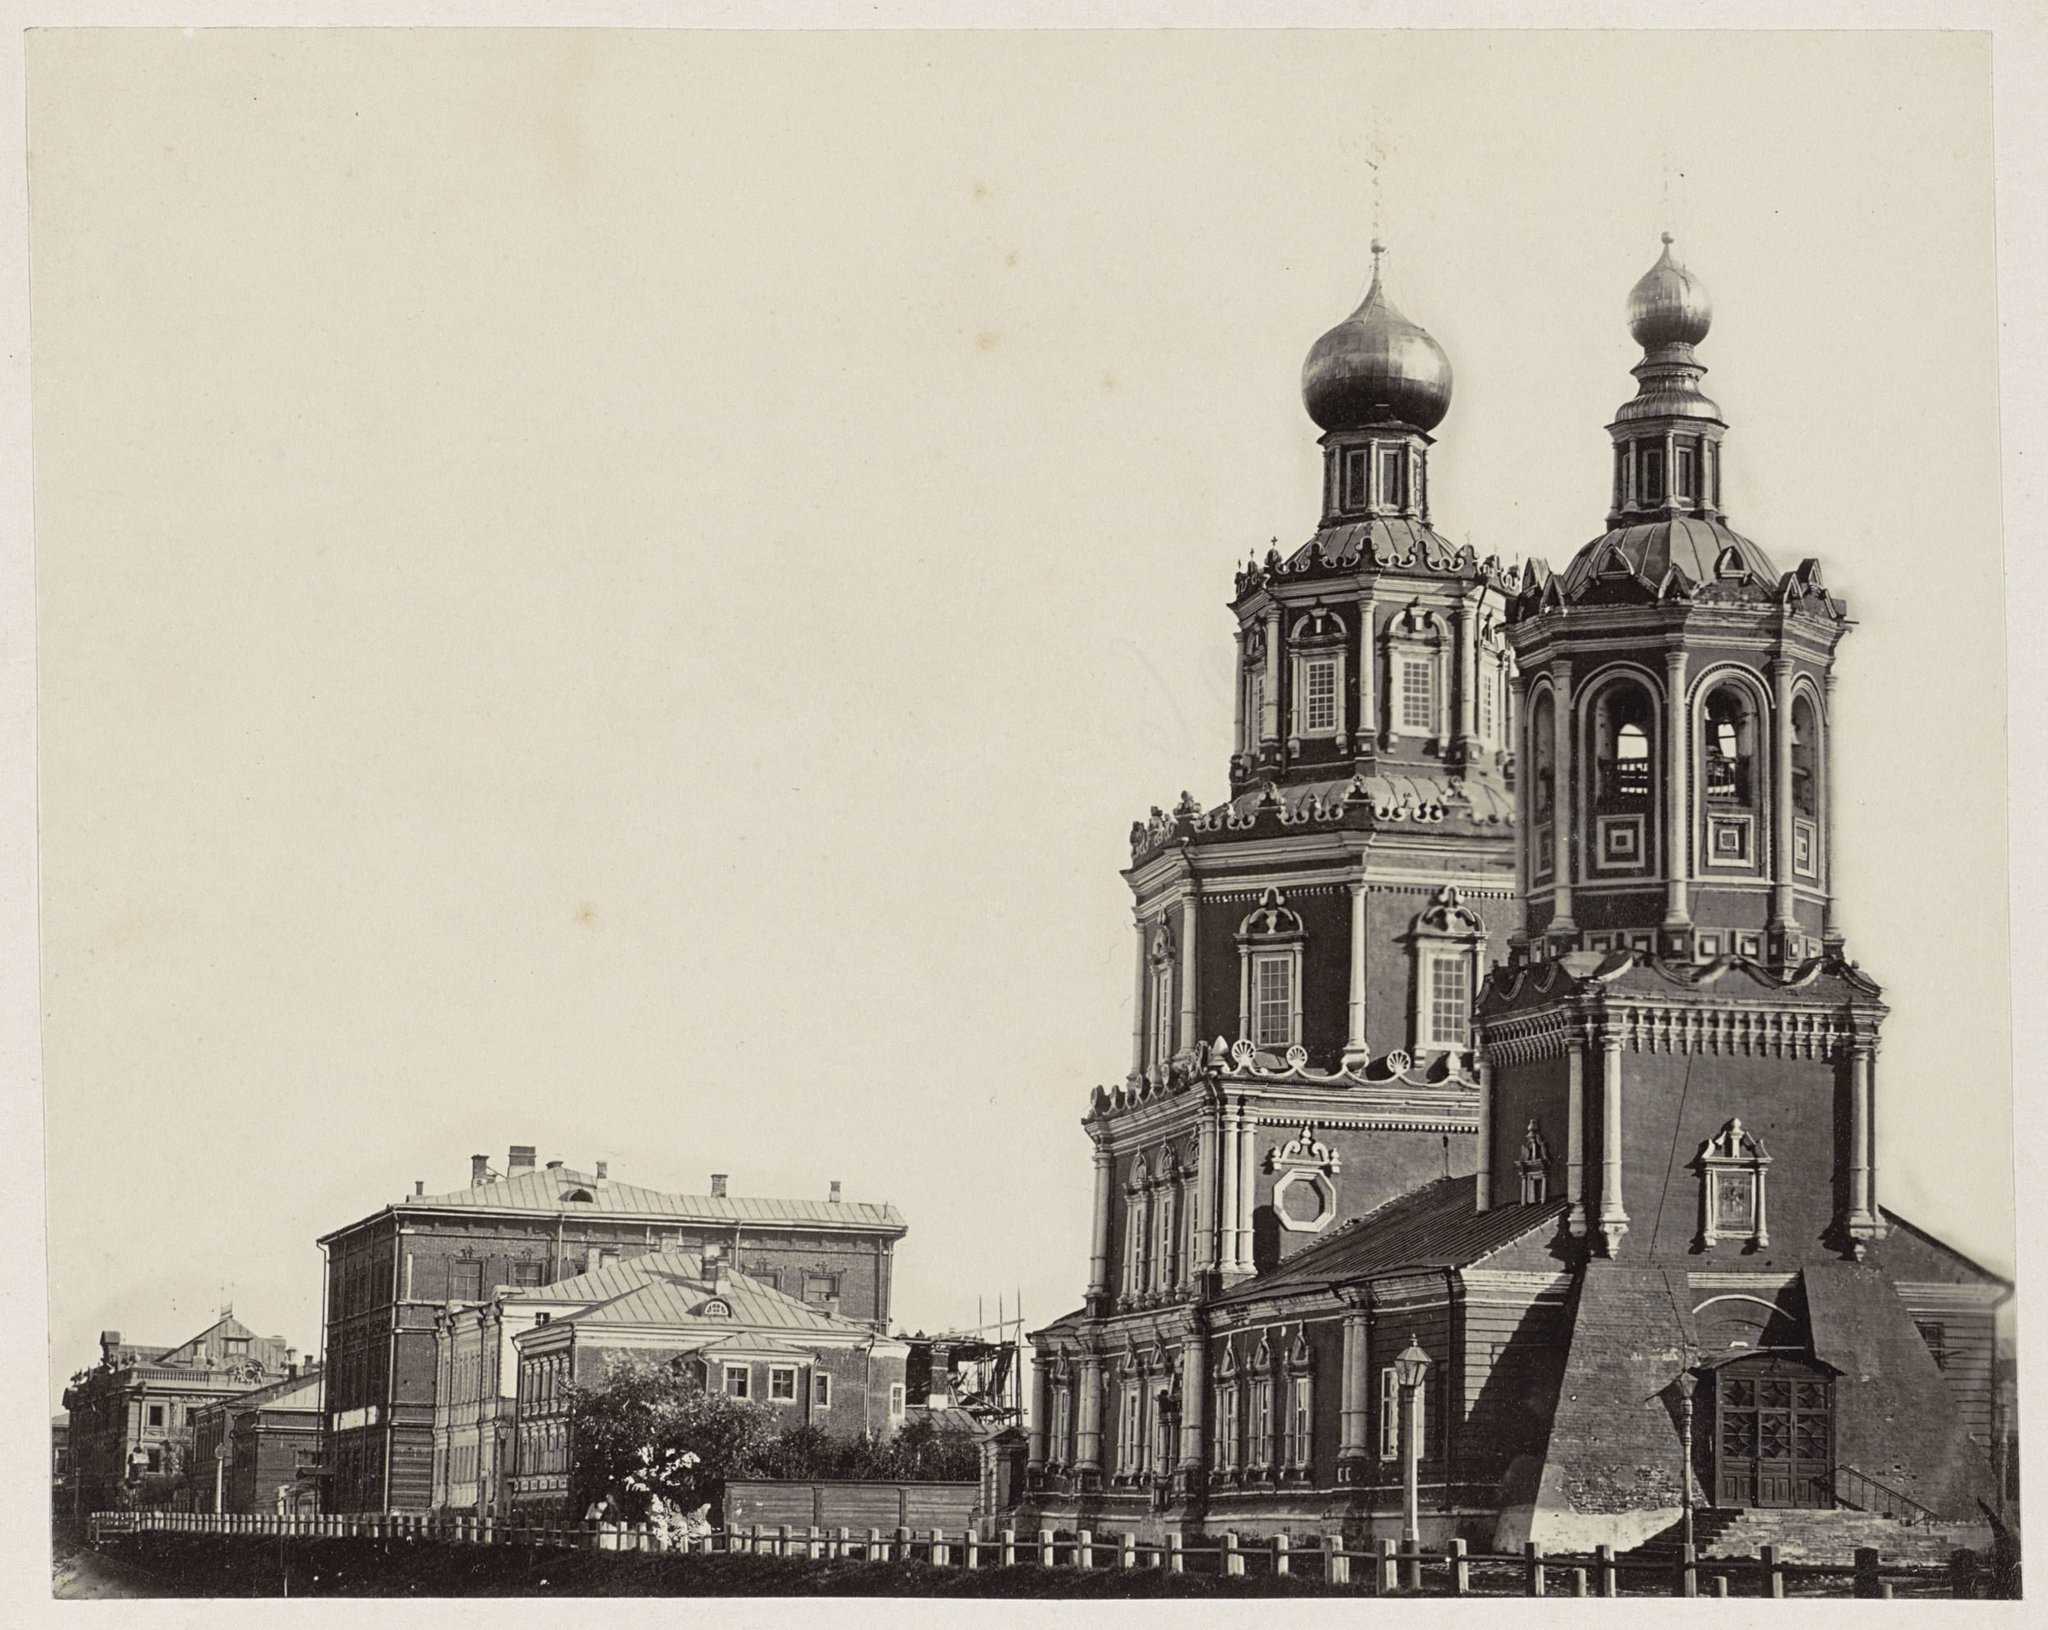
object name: photograph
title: Nischny Novgorod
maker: Anonymous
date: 1878-1890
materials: photographic support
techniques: albumen print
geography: nizhniy novgorod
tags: exterior ~ representation of a building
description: Onderdeel van Reisalbum Europese steden, vermoedelijk Zweeds.